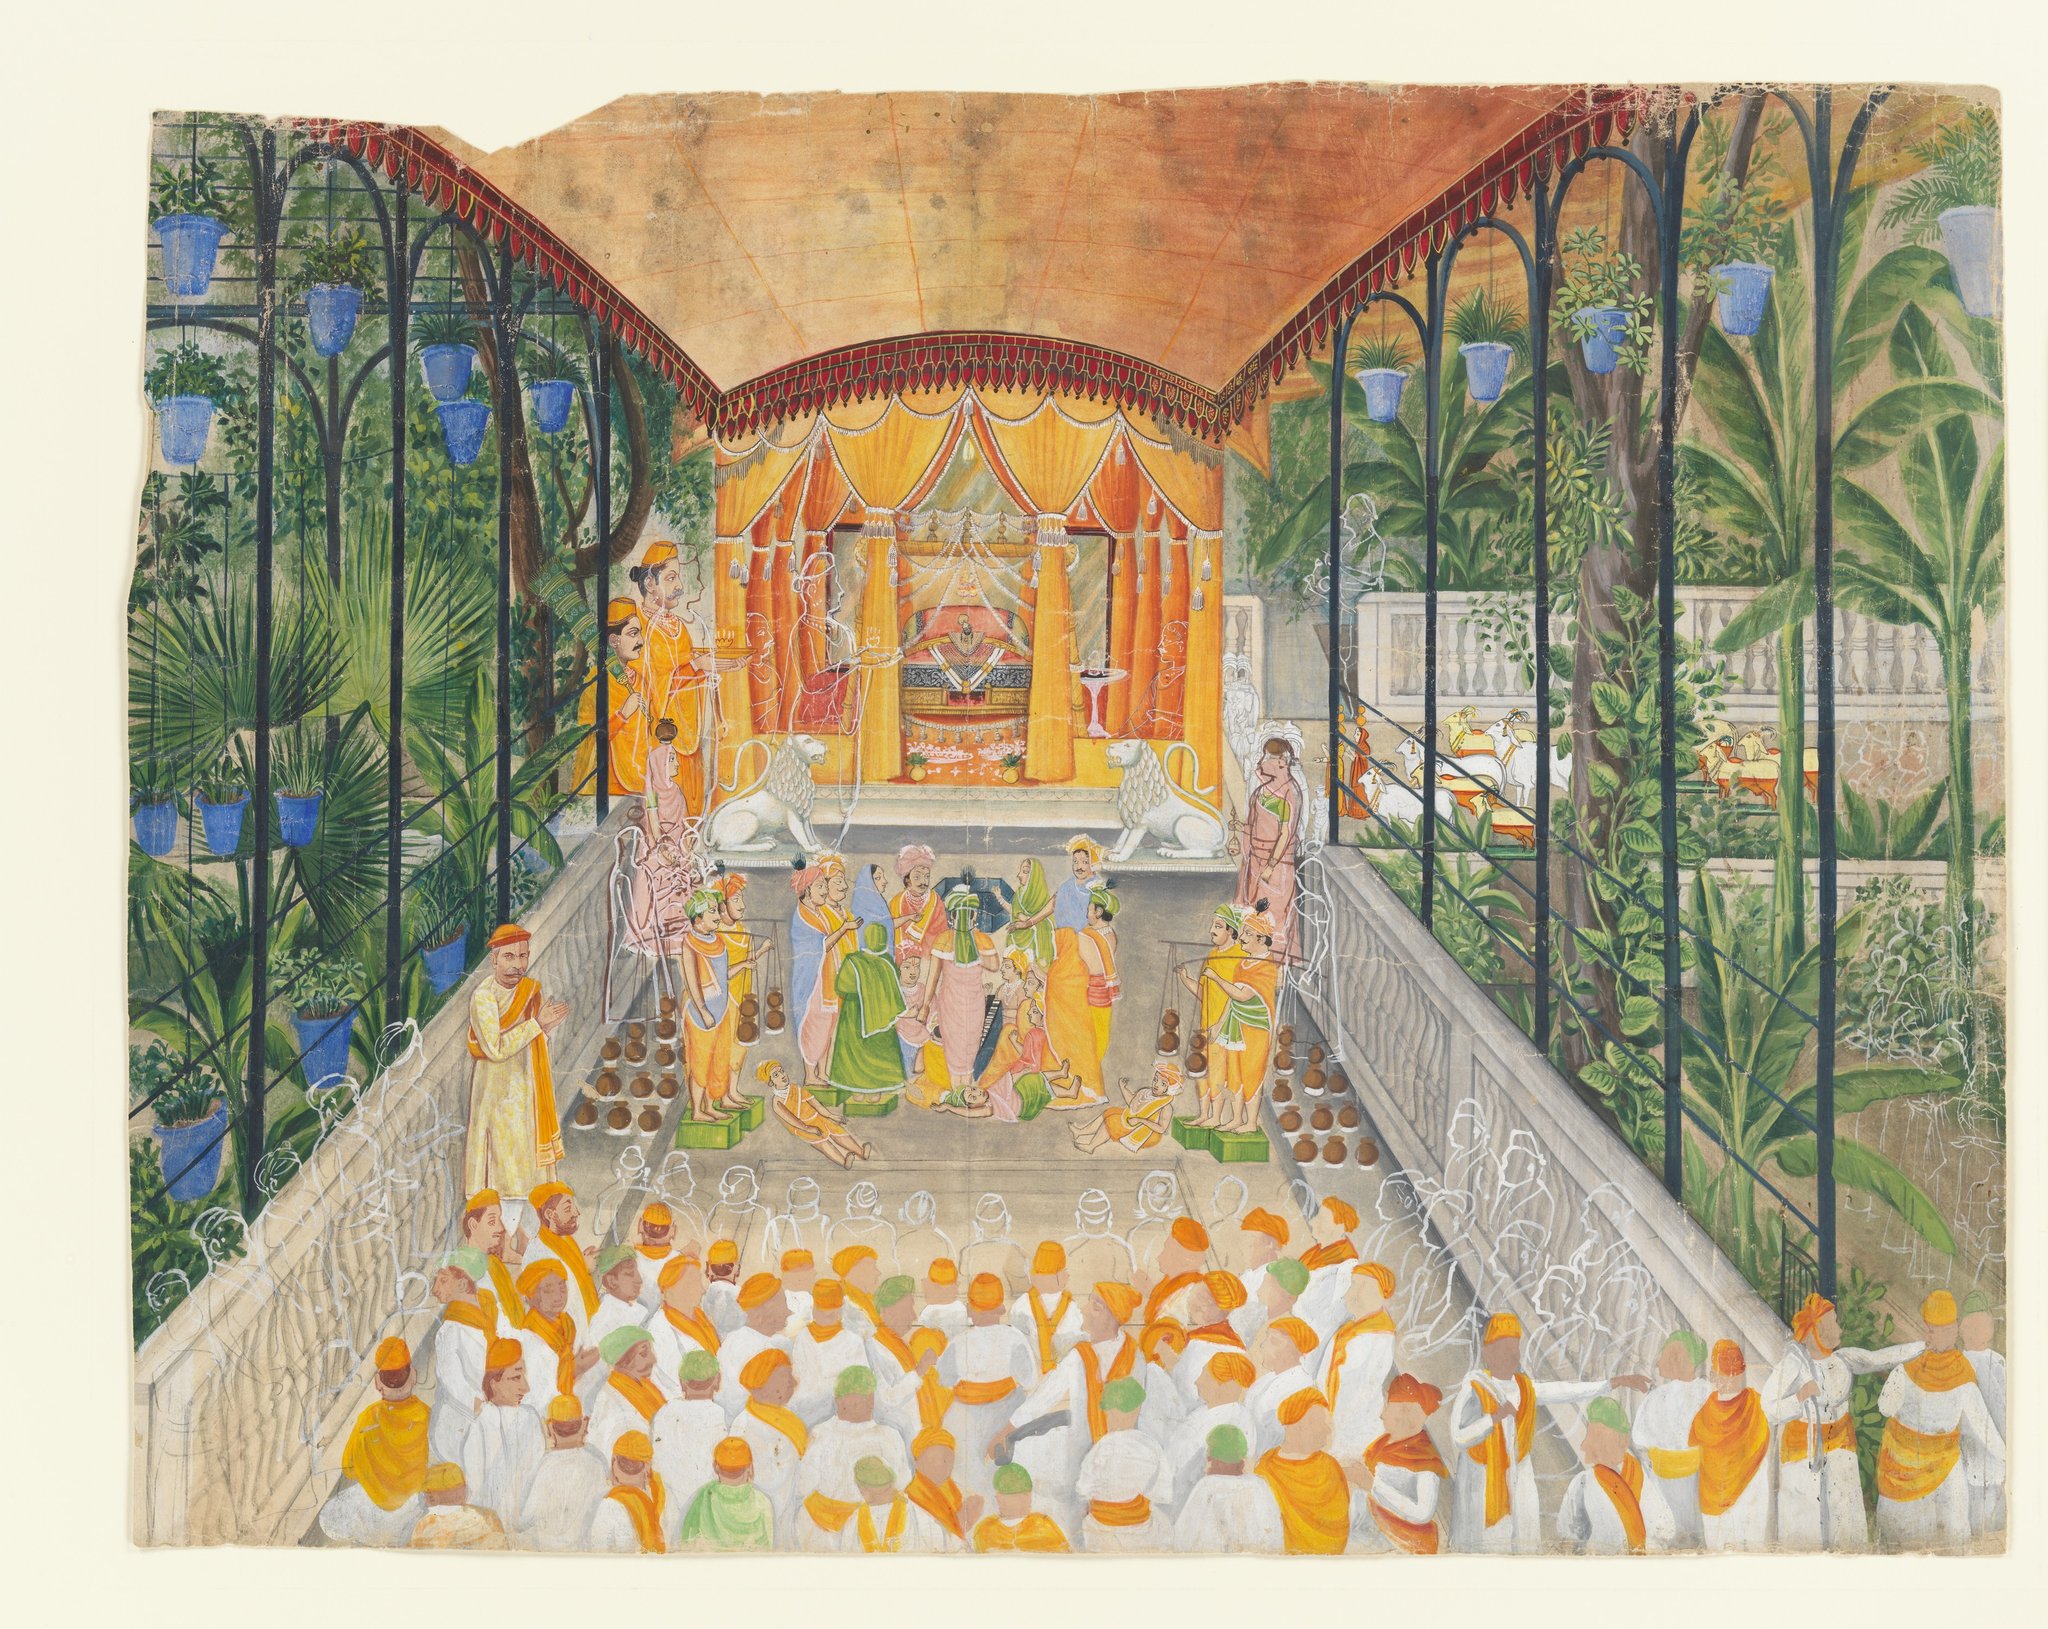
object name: painting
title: Celebration of the Birth of Krishna (Janamashtami)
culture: indian, rajasthani, nathadwara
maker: ragunath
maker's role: artist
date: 1880-1900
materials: ink, paper, watercolor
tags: lions,krishna,crowd